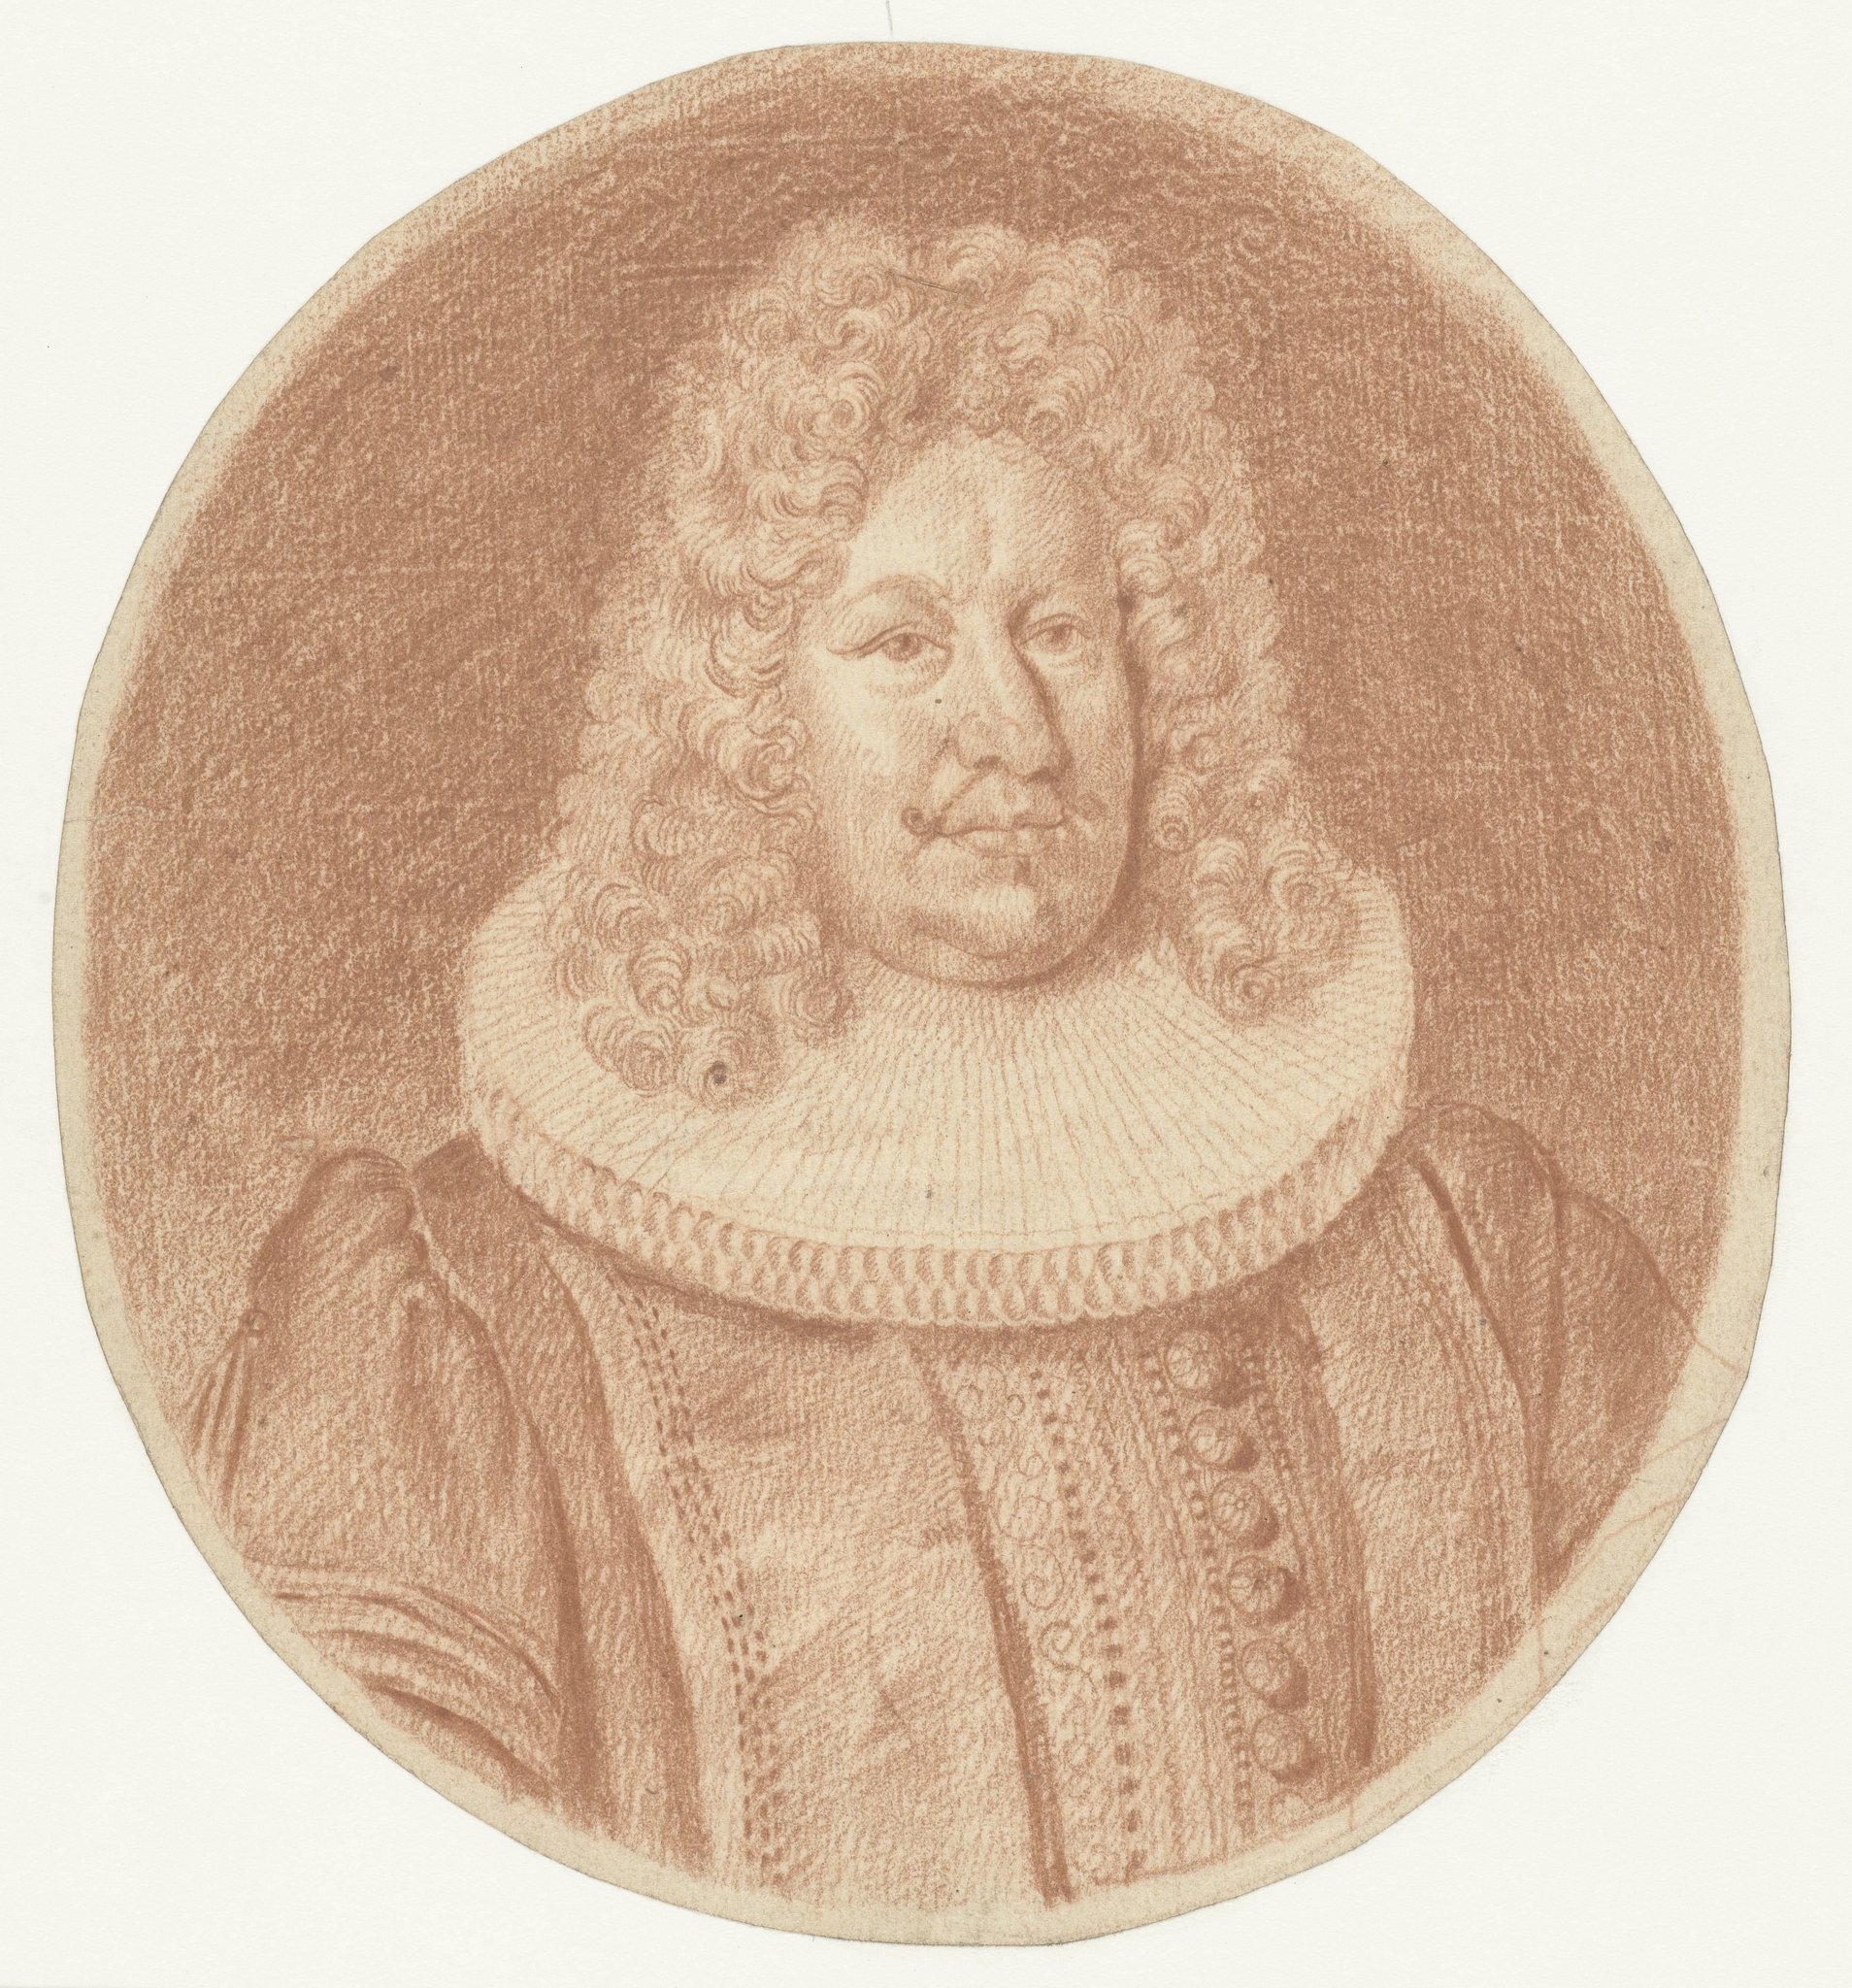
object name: drawing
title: Portret van een onbekende man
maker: Anonymous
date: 1600-1699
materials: chalk, paper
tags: anonymous historical person portrayed alone